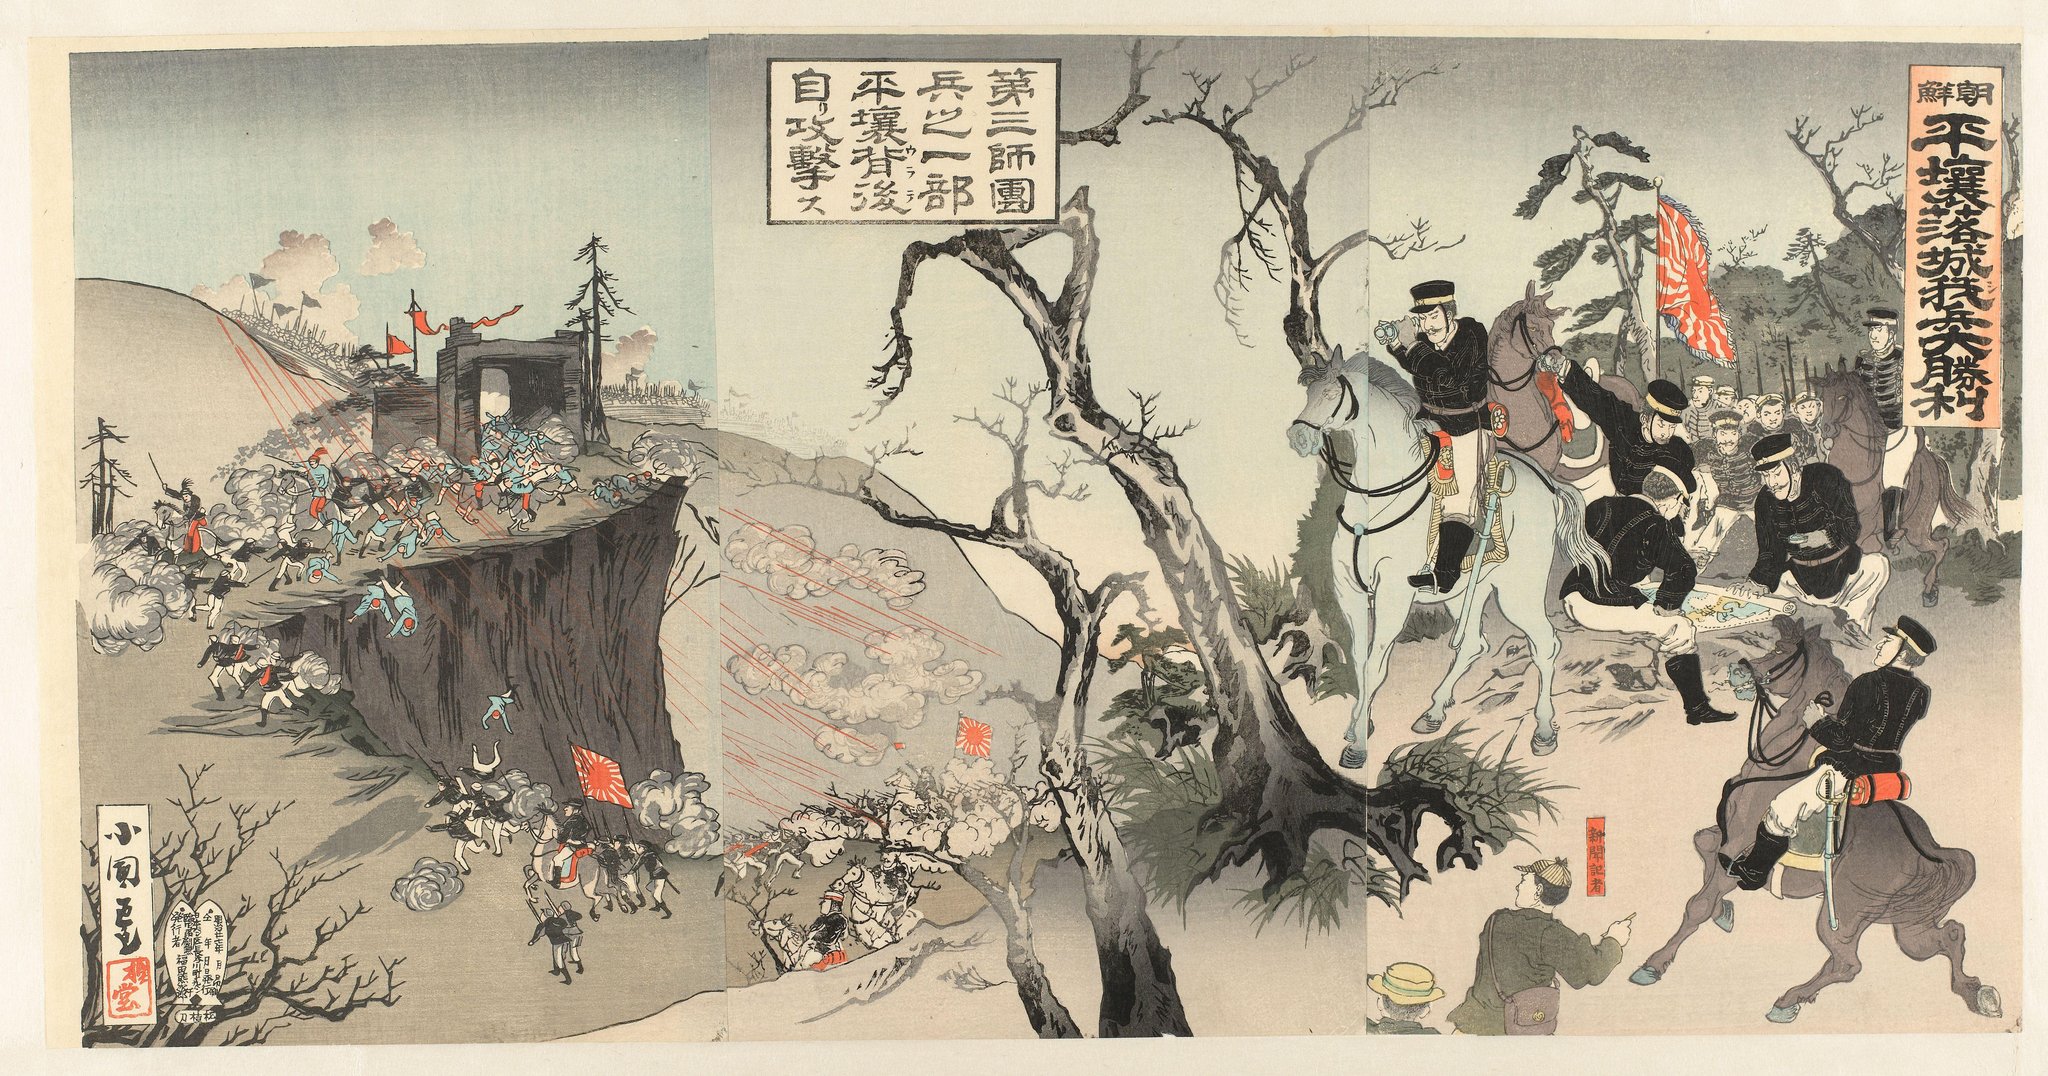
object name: triptych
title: Ons leger wint een grote overwinning bij Pyongyang in Korea, met overgave van het dorp - Een deel van de derde divisie valt Pyongyang aan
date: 1894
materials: paper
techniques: woodcut, polish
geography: japan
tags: battle, inland cliff face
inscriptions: label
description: Terwijl Generaal Ôshima aan de voorkant Pyongyang aanviel, stuurde Luitenant-Generaal Nozu zijn mannen vanaf een andere kant voor een verassingsaanval. Dit zorgde voor paniek bij de Chinezen, waardoor zij meer dan 2000 soldaten verloren in deze strijd op 8 augustus 1894. Linksonder staat een journalist van de krant.